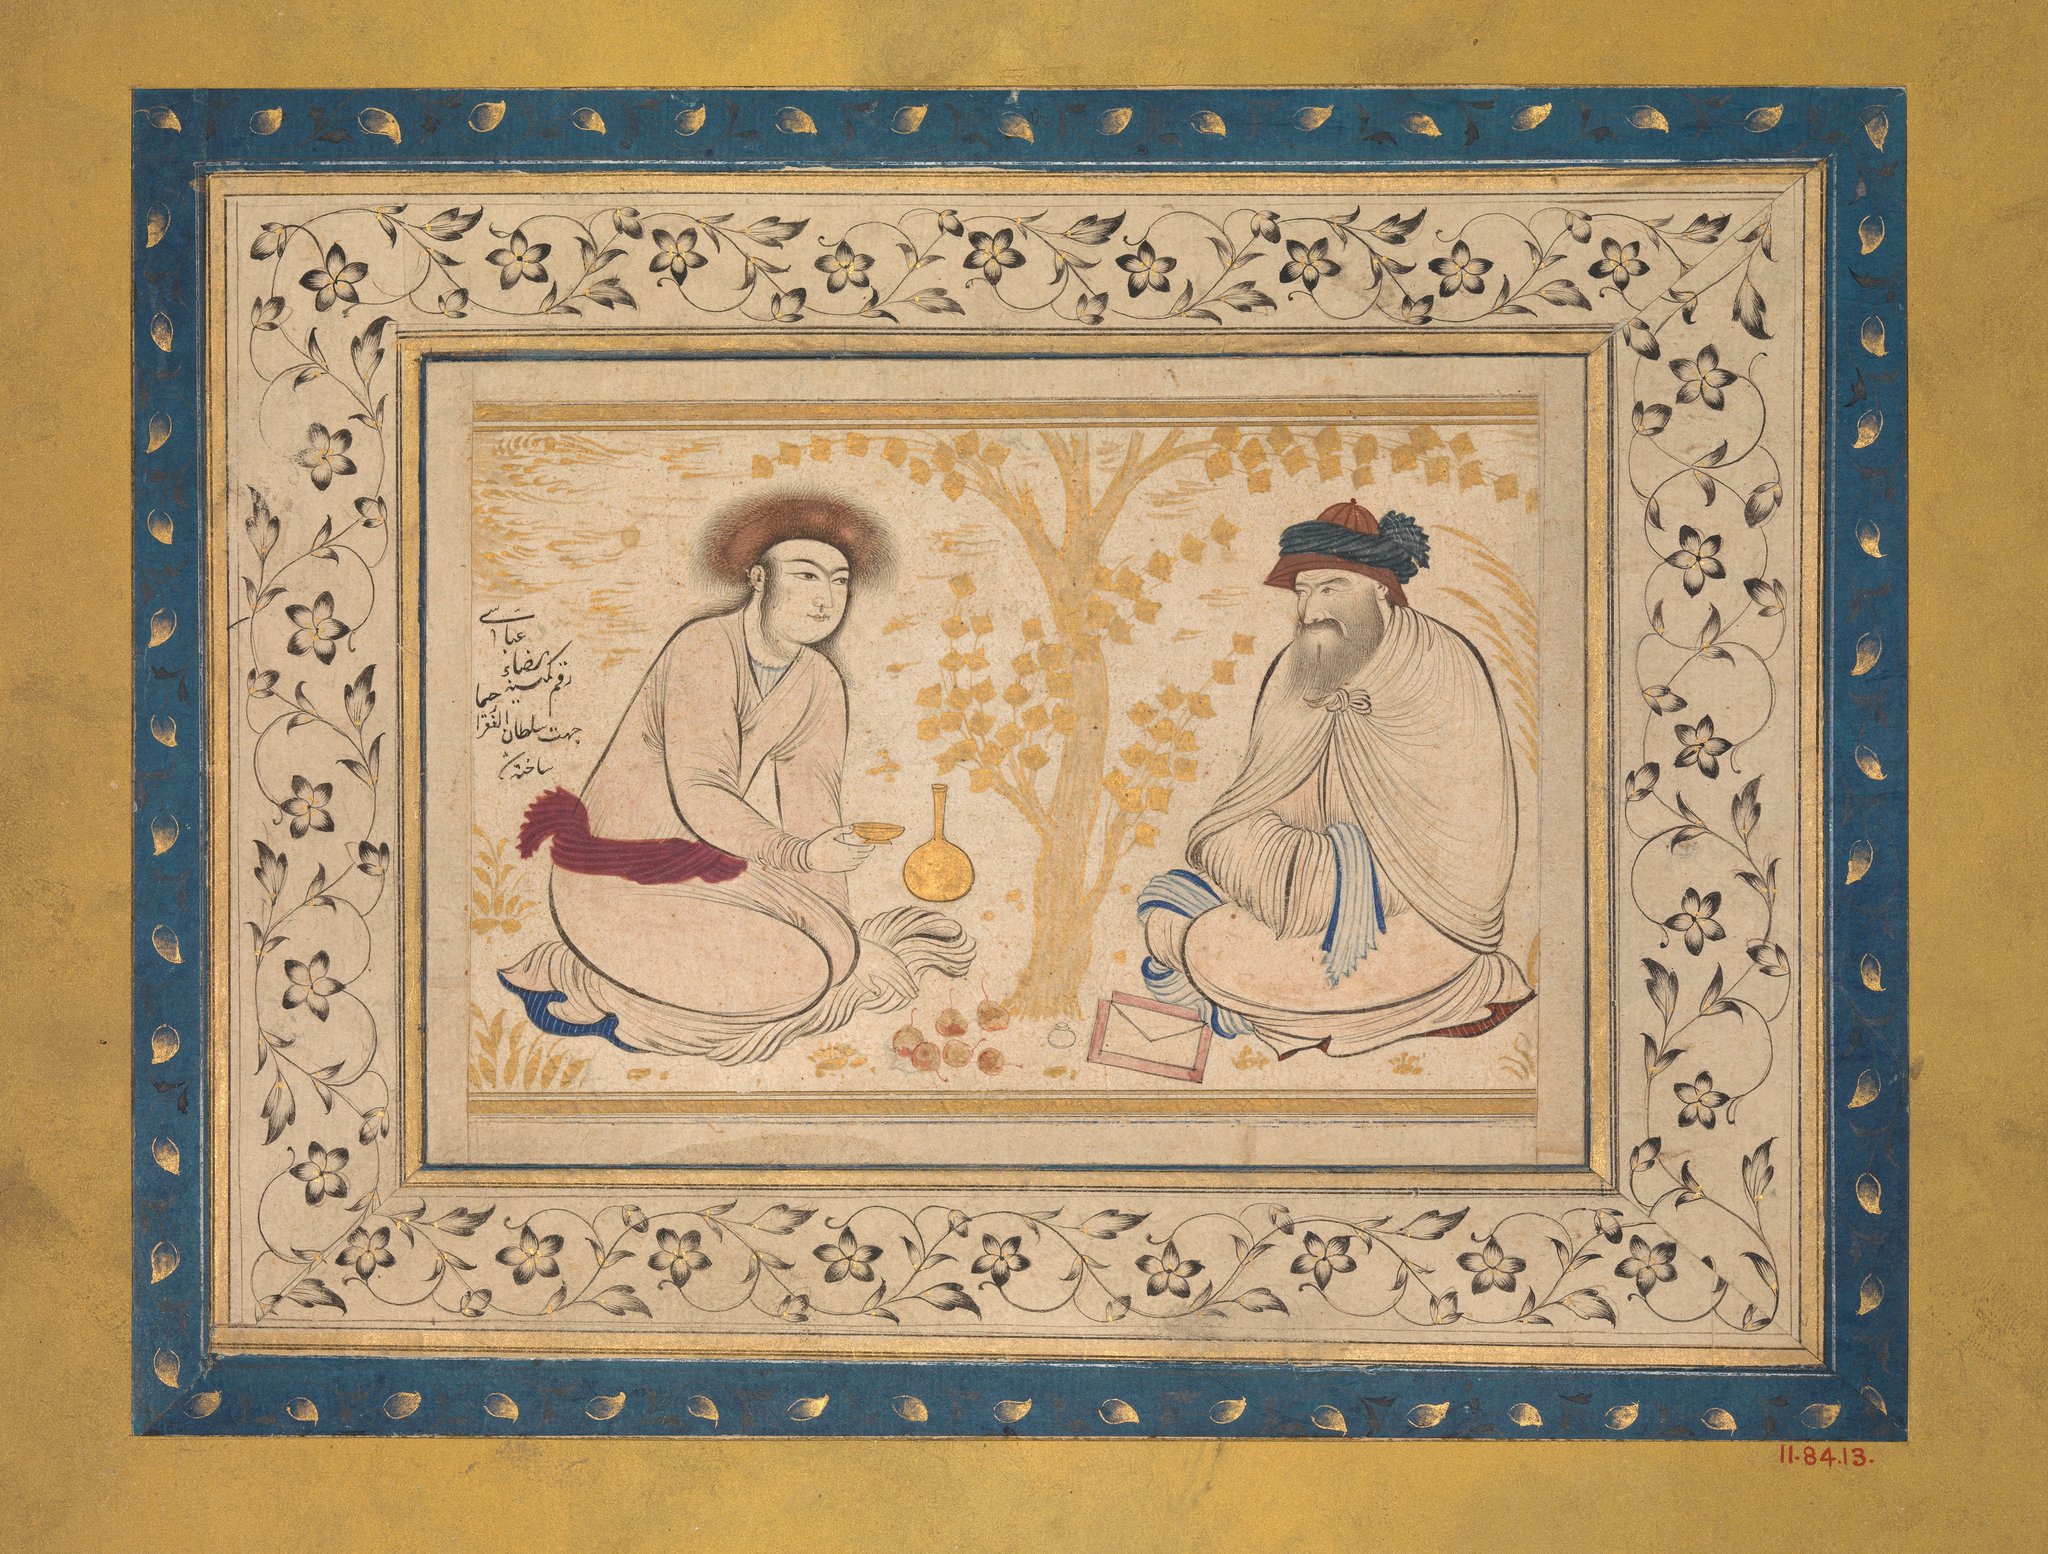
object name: illustrated single work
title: Youth and Dervish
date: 1626-1650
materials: gold, ink, paper, watercolor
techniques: drawing, tinting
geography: iran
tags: men,trees